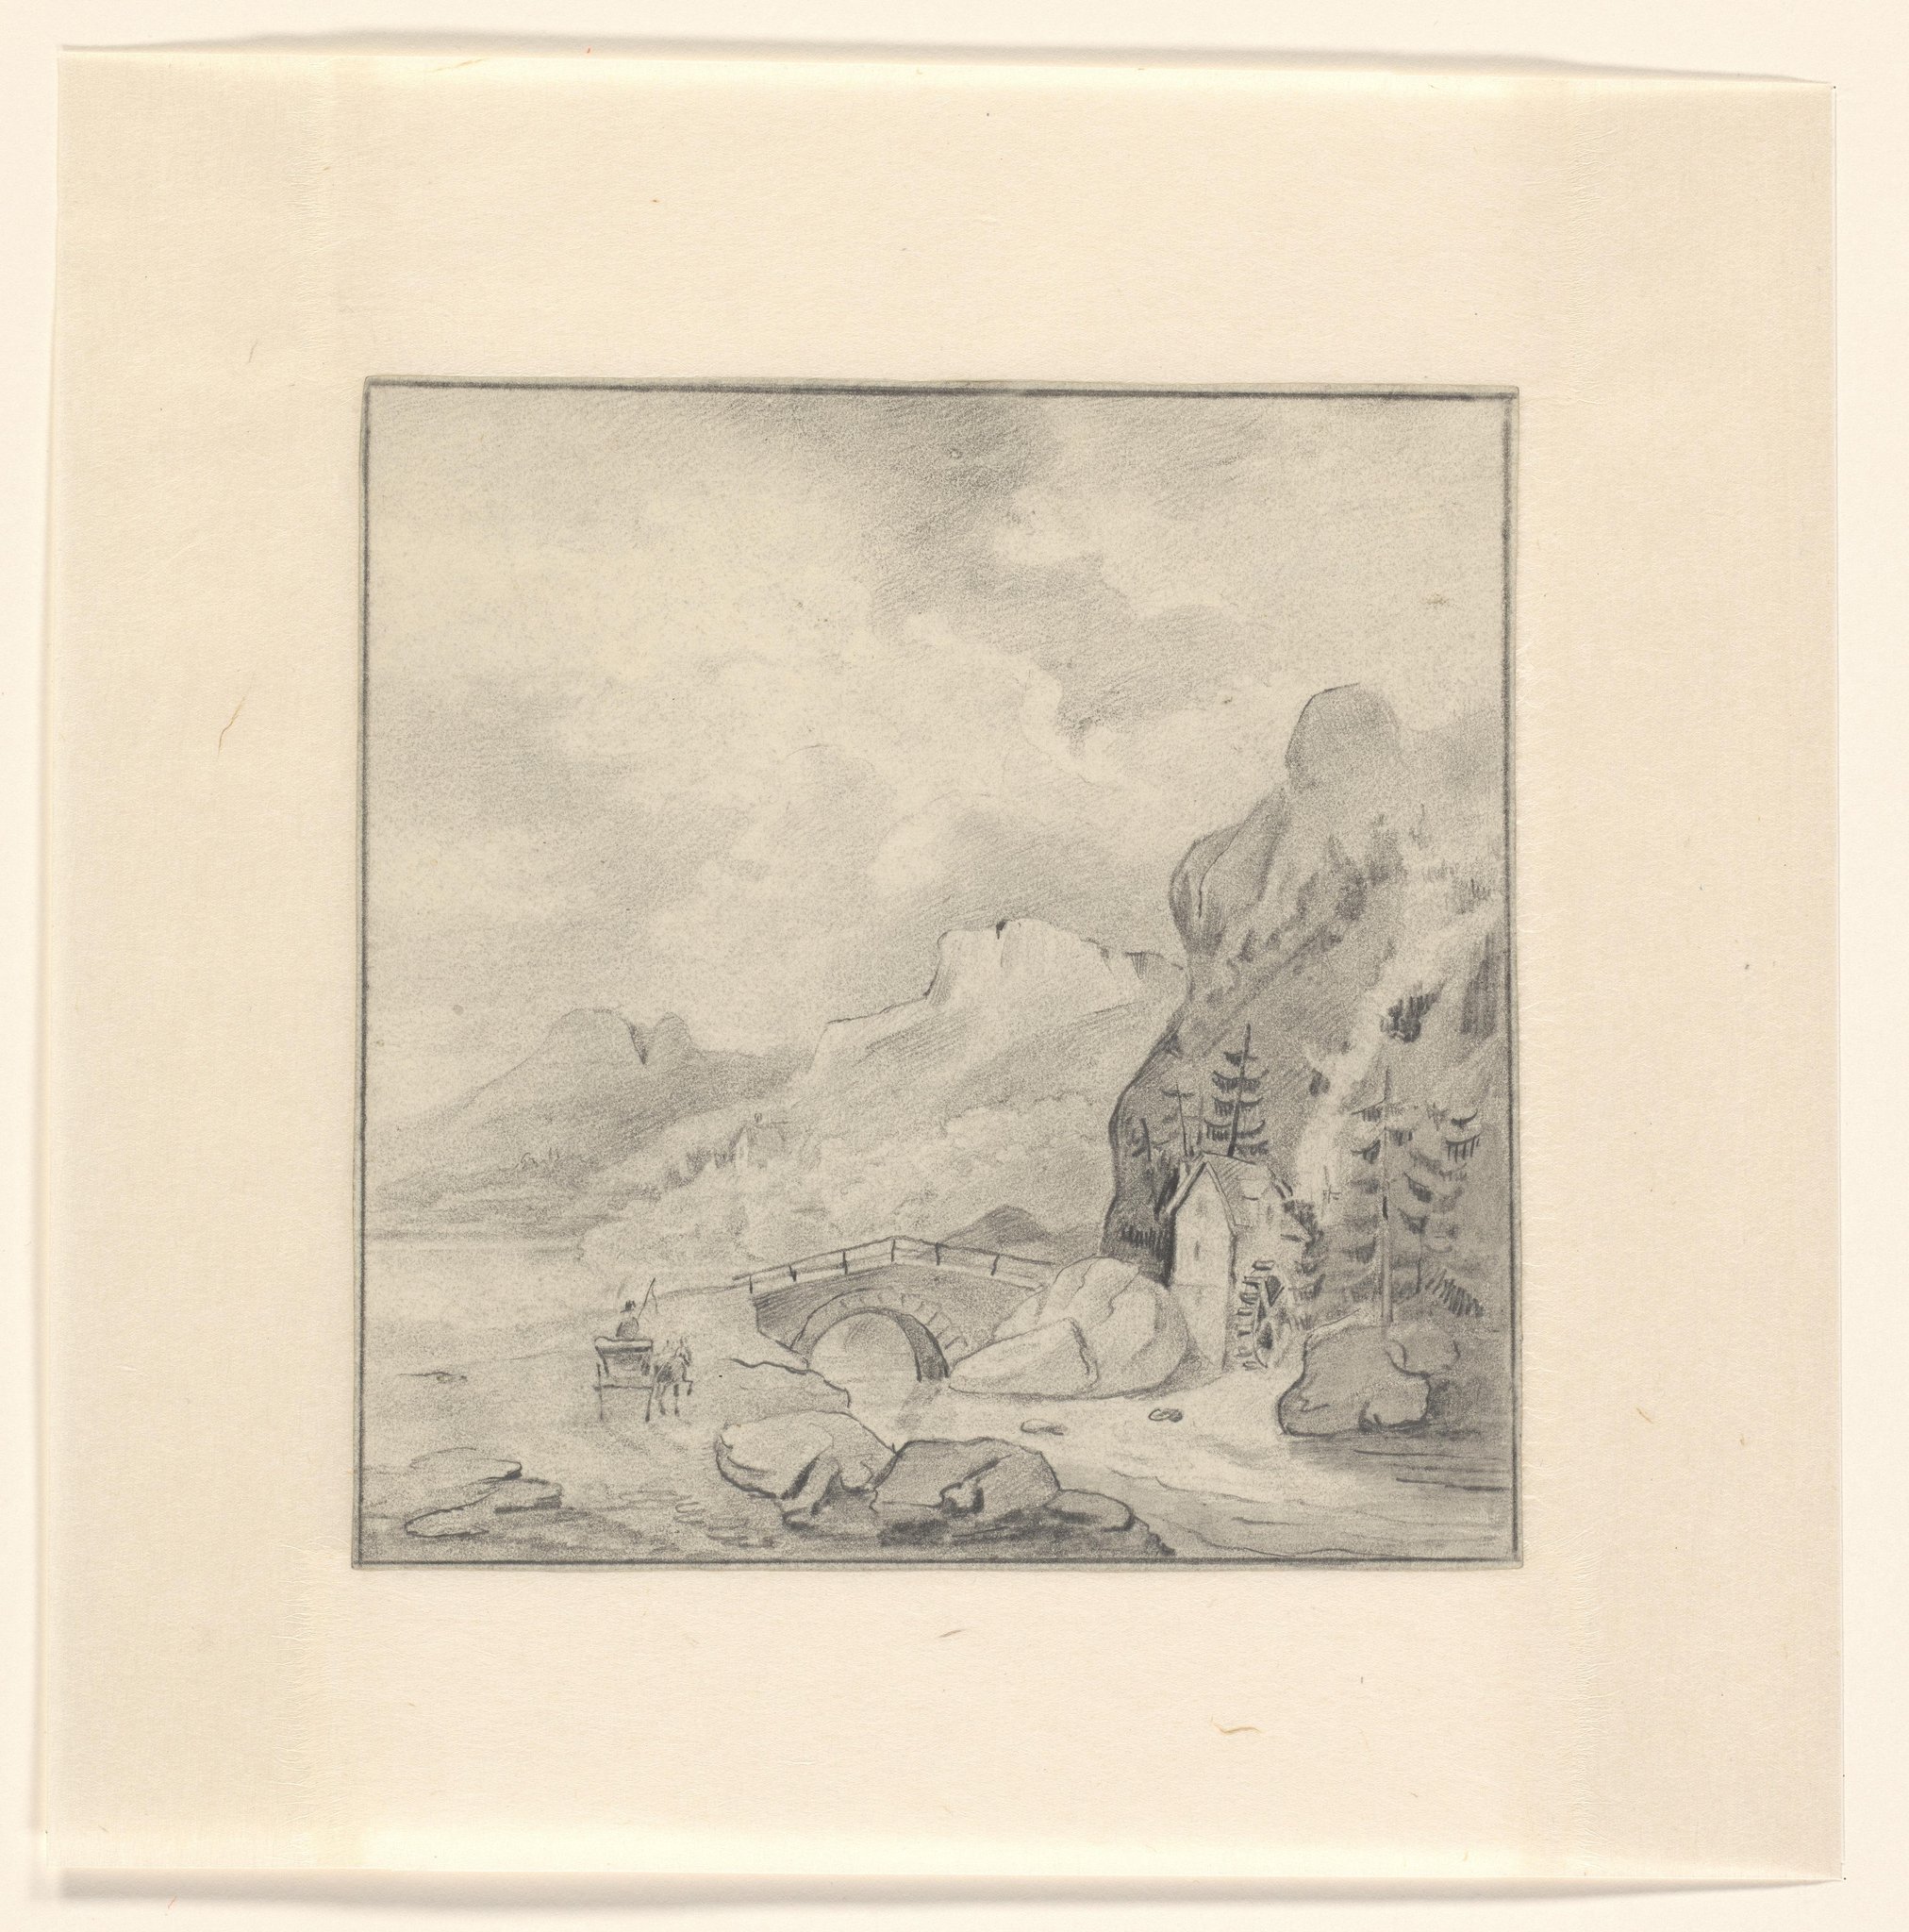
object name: drawing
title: Berglandschap met watermolen en stenen brug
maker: johannes van reijn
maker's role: draughtsman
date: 1800-1900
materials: paper, pencil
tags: landscape with bridge, viaduct or aqueduct, watermill, mountains